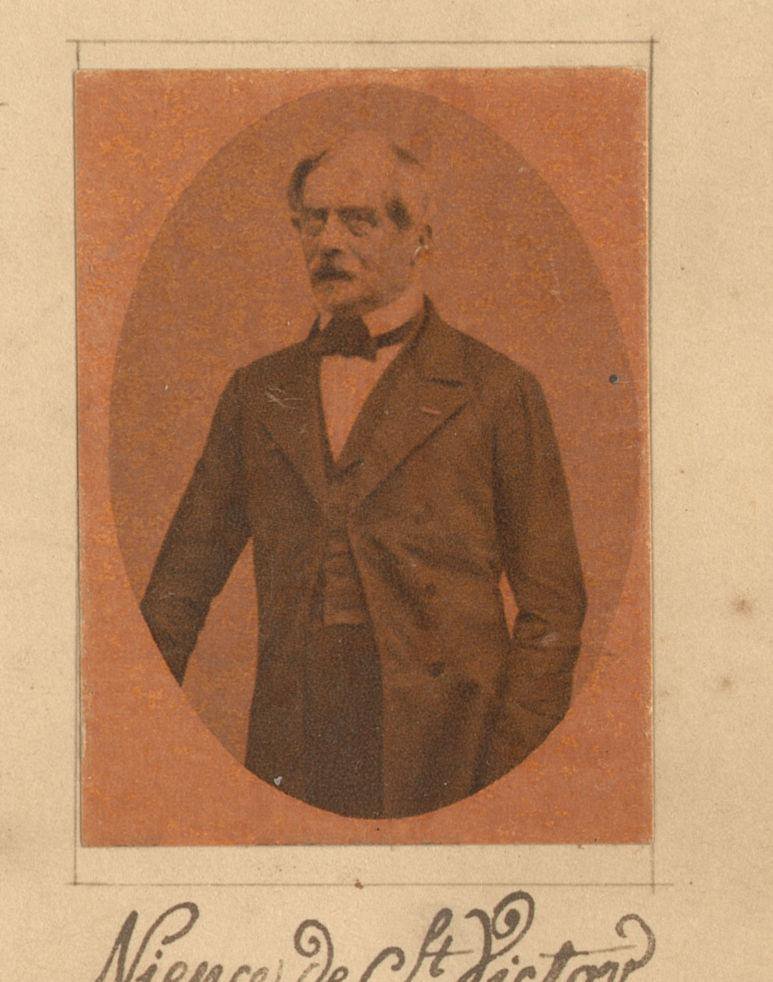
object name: photomechanical print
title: Niepce de St Victor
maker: Anonymous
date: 1845-1870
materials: paper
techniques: rotogravure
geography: france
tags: abel niépce de saint-victor, adult man, historical persons, france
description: Deze prent maakt deel uit van een album.